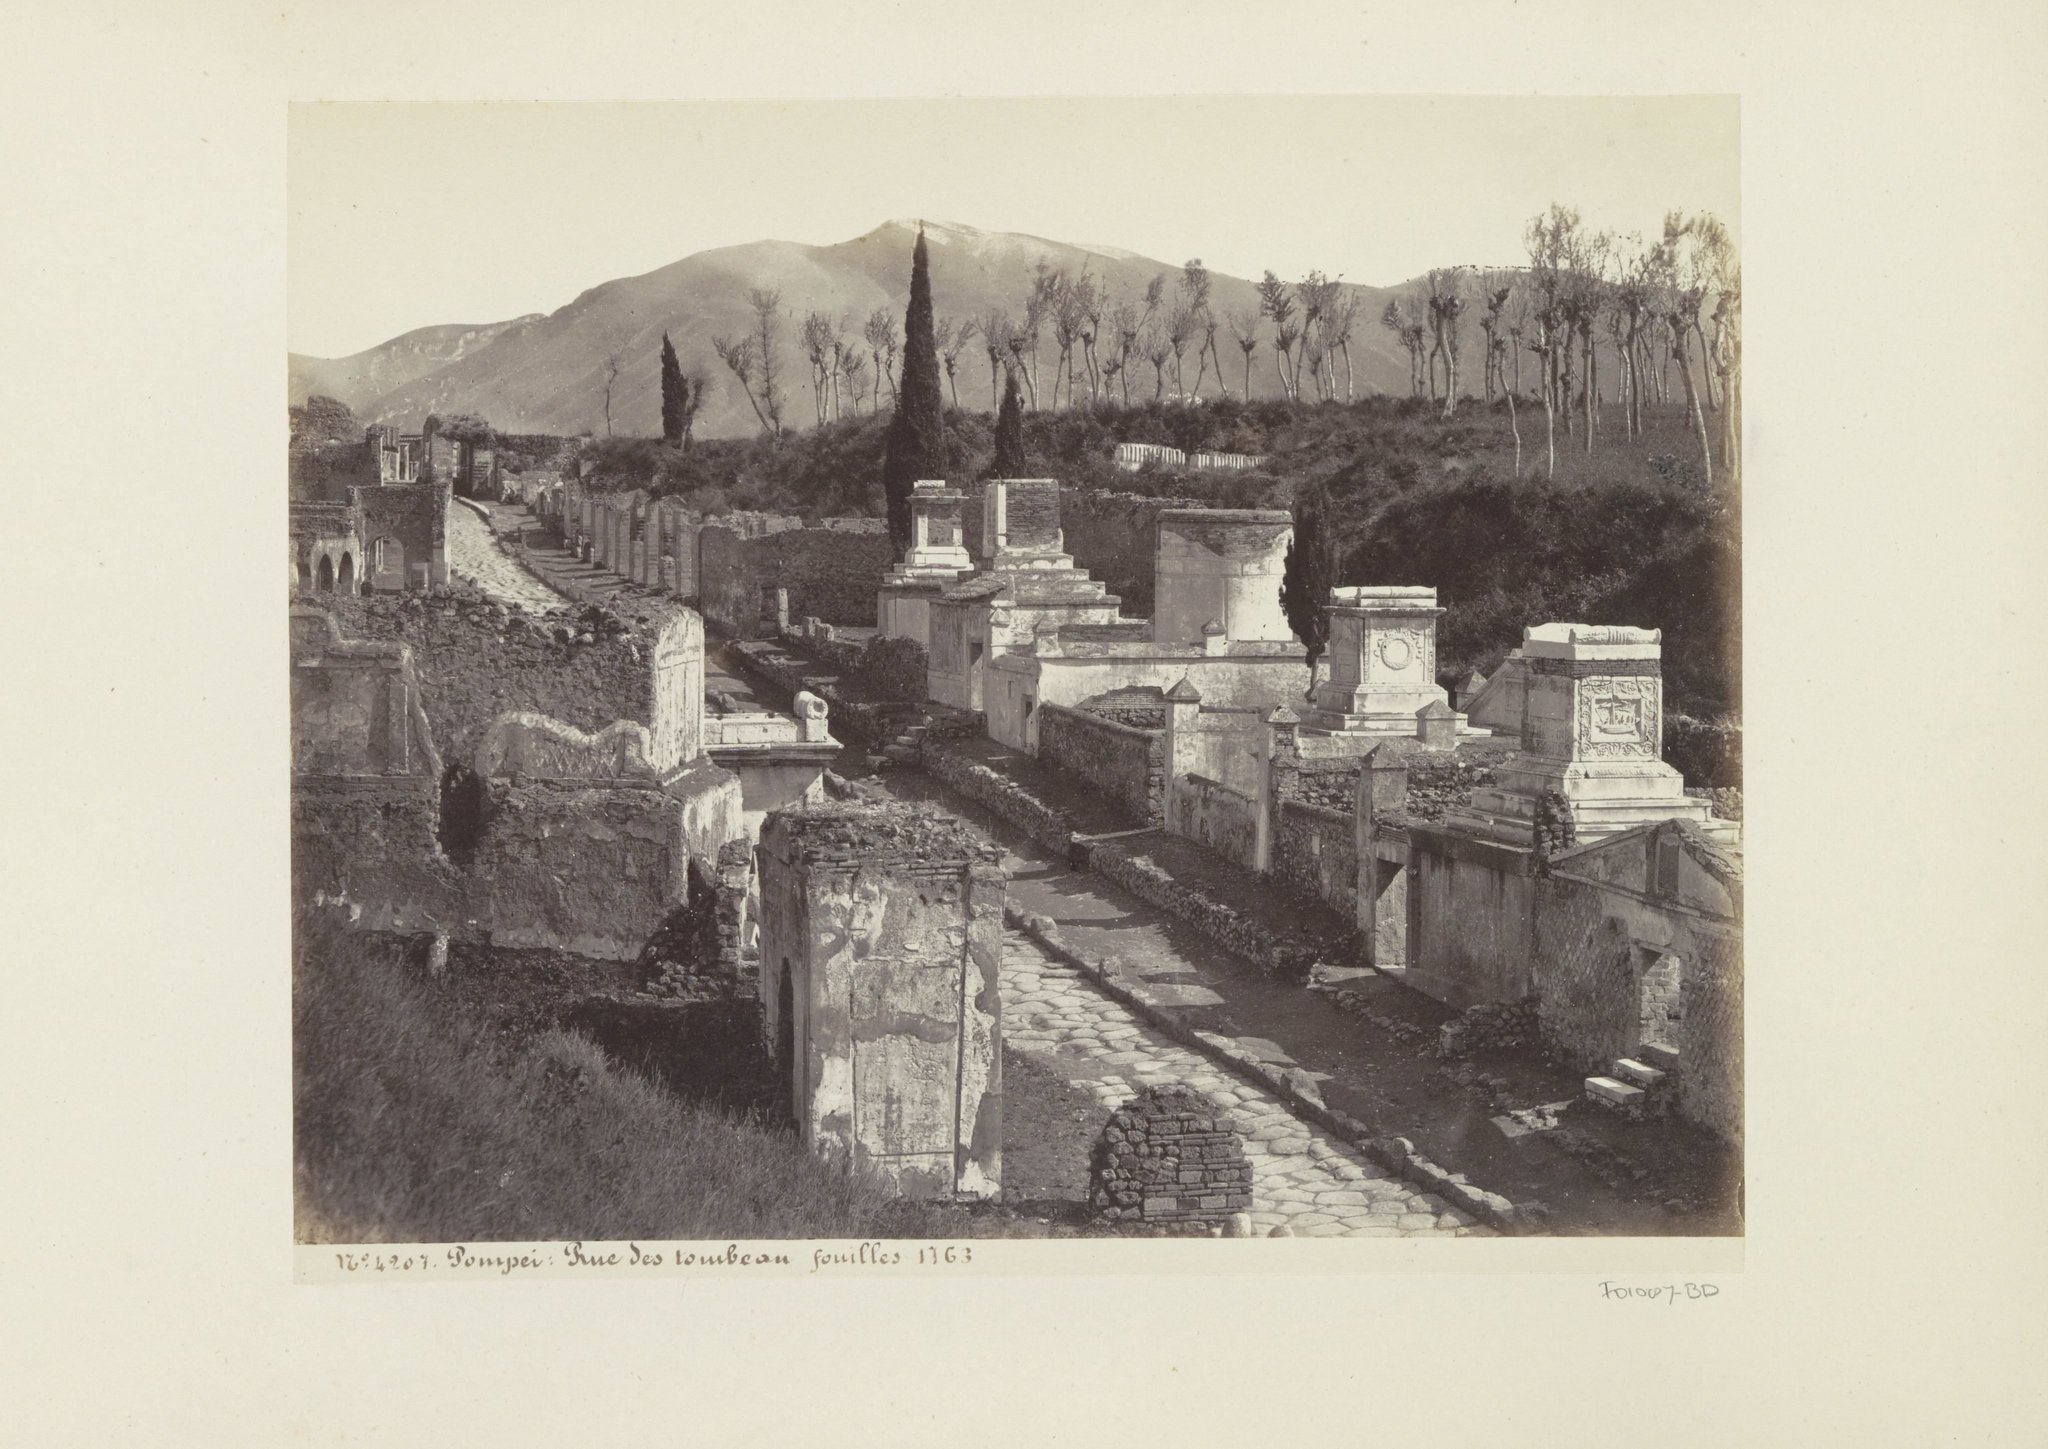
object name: photograph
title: Restanten van gebouwen aan de Straat met Graftombes (Via delle Tombe) in Pompei, met op de achtergond de Vesuvius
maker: Anonymous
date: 1865-1875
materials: paper, photographic support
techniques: albumen print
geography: pompeii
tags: grave, tomb, excavation ~ archaeology, street, pompeii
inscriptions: negative number: ‘4207’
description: Onderdeel van Reisalbum met foto's van bezienswaardigheden in Napels en omgeving.